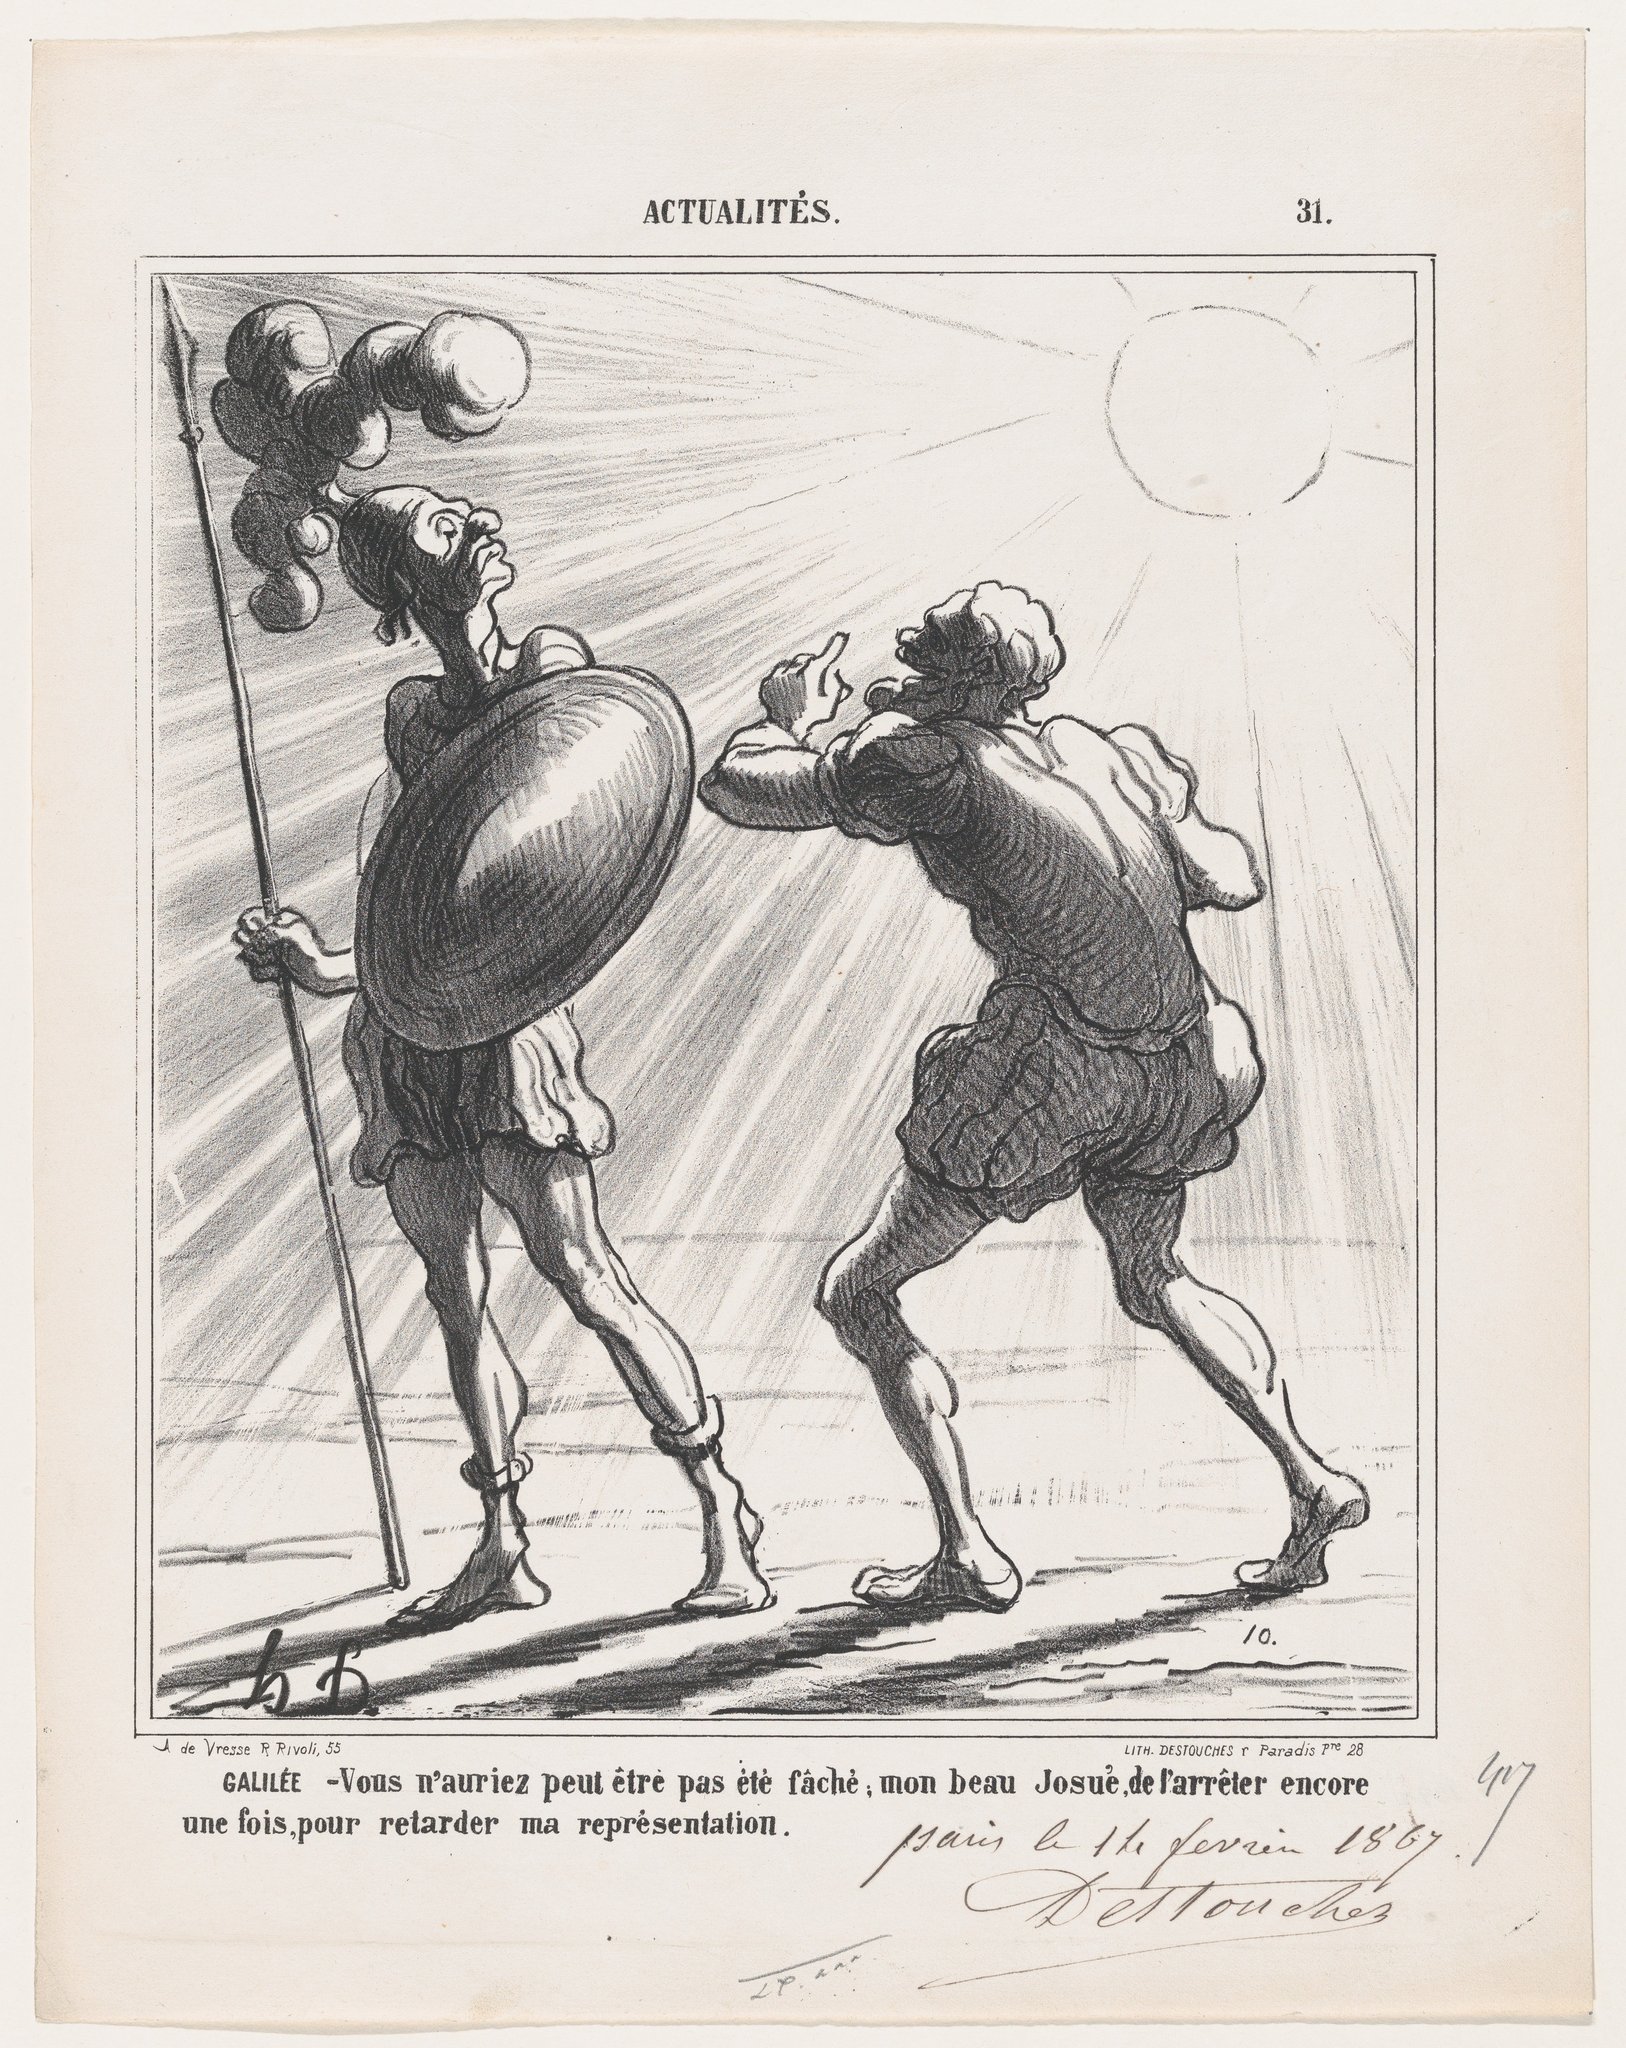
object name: print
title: Galileo: You wouldn't be annoyed, my good Joshua, to stop the sun once again for the sake of my show, from 'News of the day,' published in Le Charivari, February 22, 1867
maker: honoré daumier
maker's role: artist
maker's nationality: french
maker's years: 1808-1879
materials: ink, paper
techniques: lithograph, pen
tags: soldiers,shields,spears,men,sun